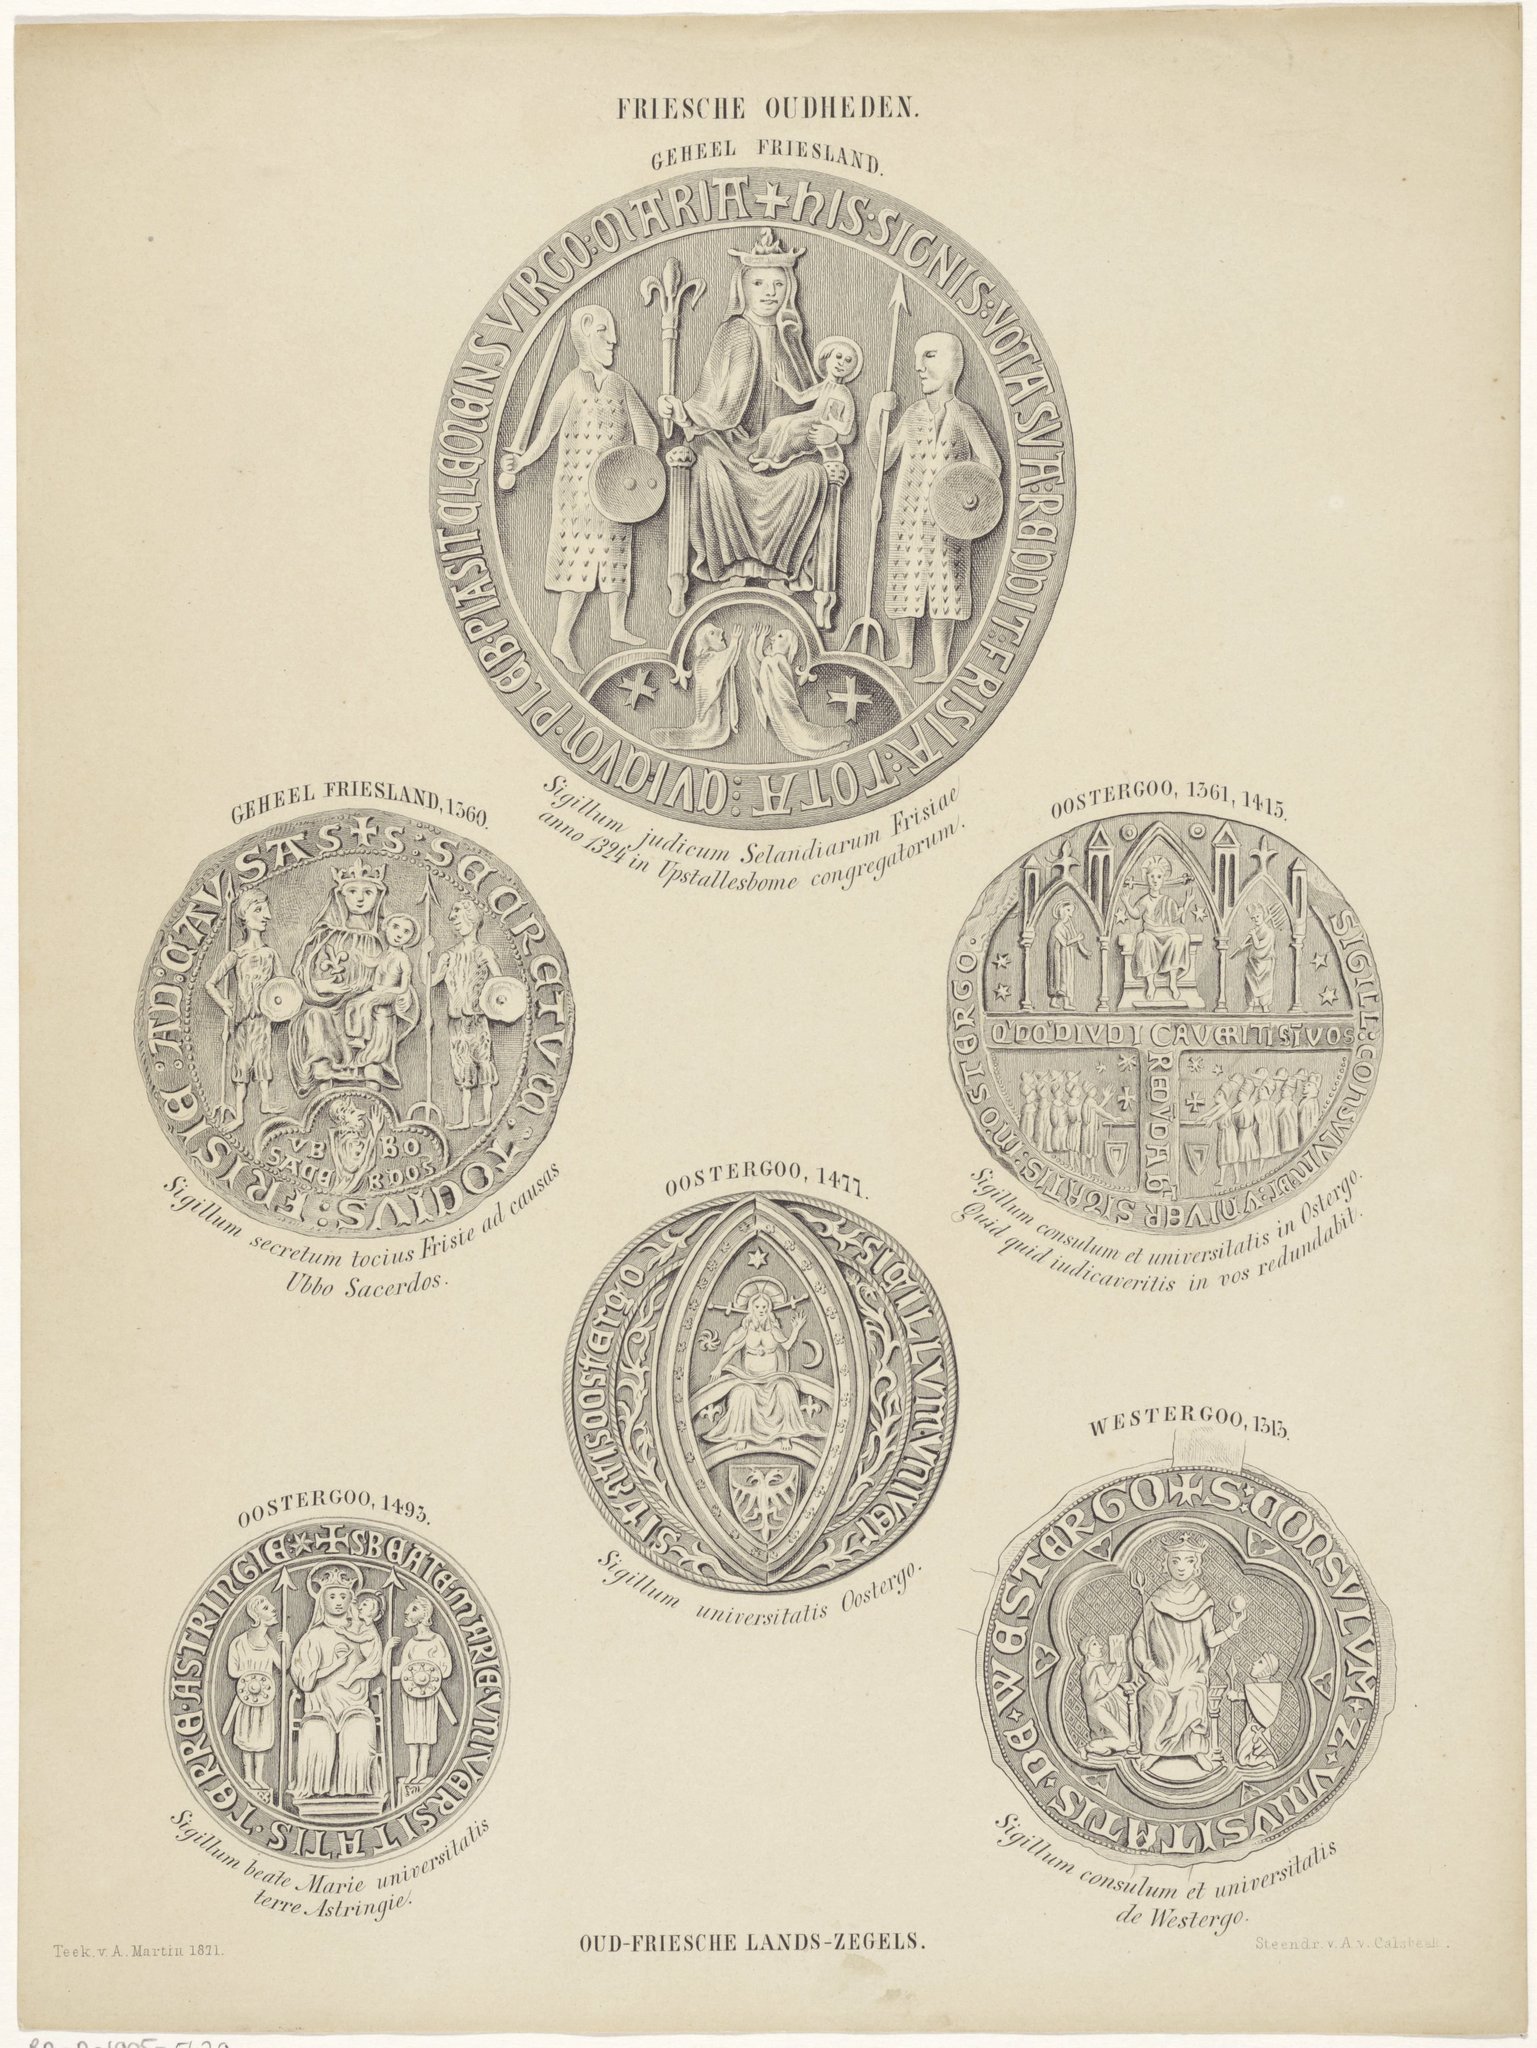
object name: print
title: Oud-Friesche Lands-Zegels.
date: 1871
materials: paper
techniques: lithograph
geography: netherlands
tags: seal, stamp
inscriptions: collector's mark: Lugt 2228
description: Afgebeeld zijn een grote en vijf kleinere zegels. Bij iedere zegel staat vermeld tot welk deel van Friesland deze behoort. Op alle zegels staat een tronende figuur en is de rand gedecoreerd met tekst. Op de bovenste en grootste zegel zit een tronende Maria met Christus in haar schoot. Links en rechts van haar wildemannen met een schild en zwaard of speer.